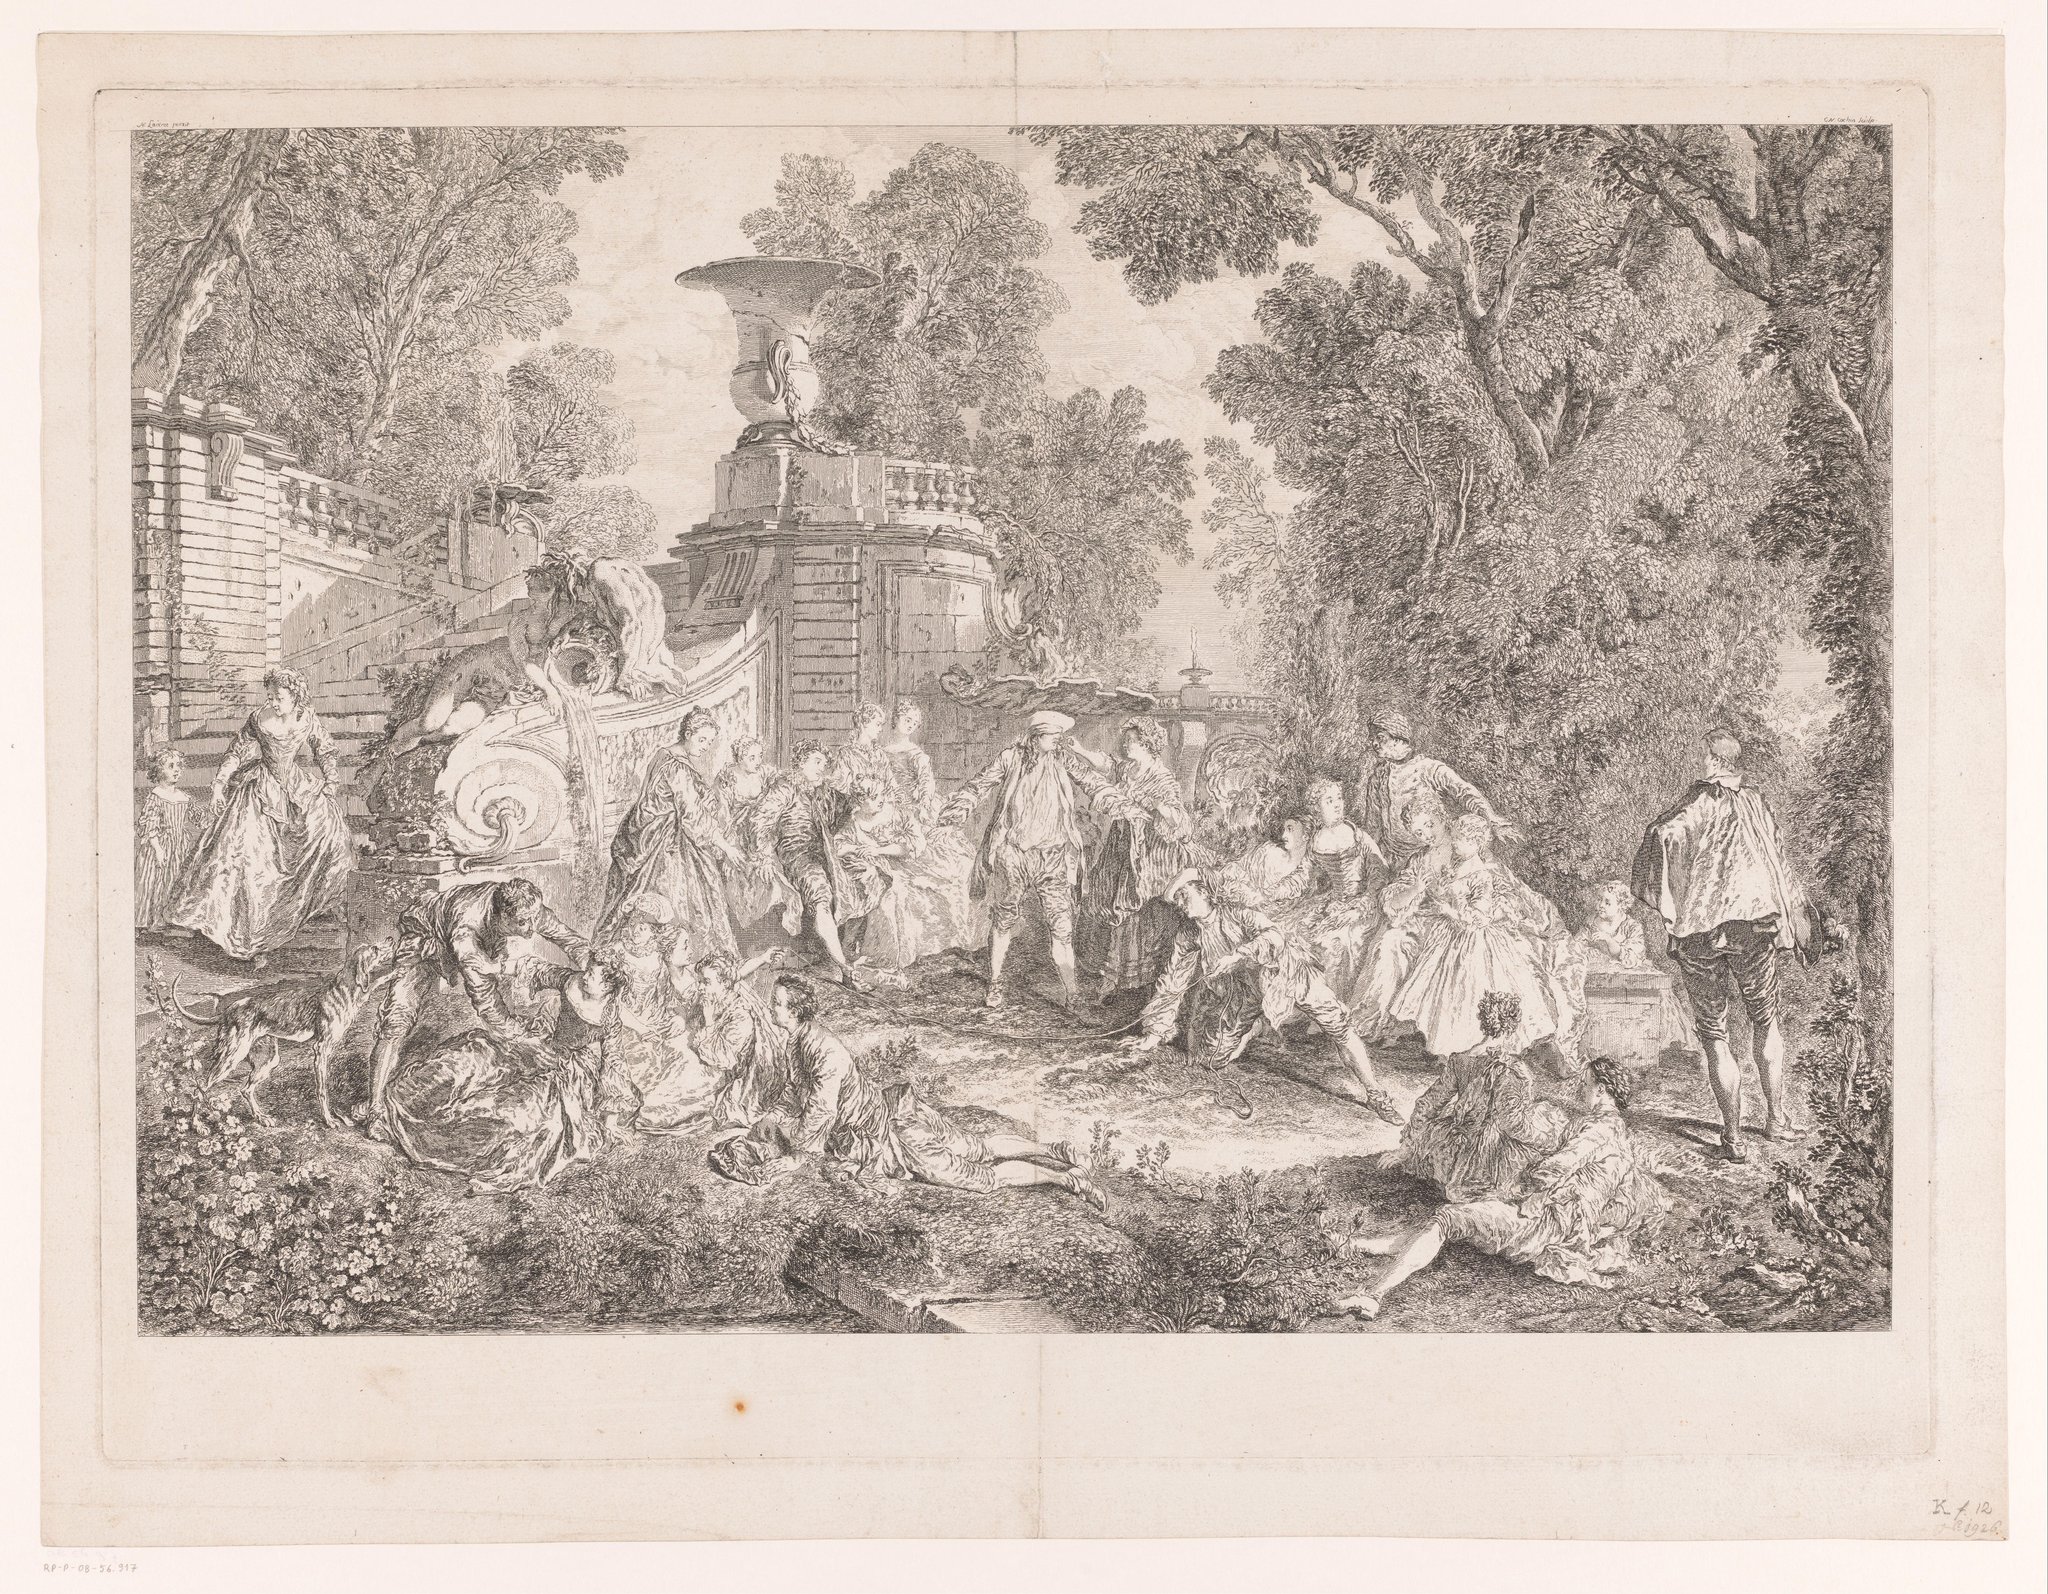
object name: print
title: Blindemannetje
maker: charles nicolas cochin (ii)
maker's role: draughtsman, print maker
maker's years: 1715-1790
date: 1725-1790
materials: paper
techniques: etching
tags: blind-man's buff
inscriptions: collector's mark: Lugt 240